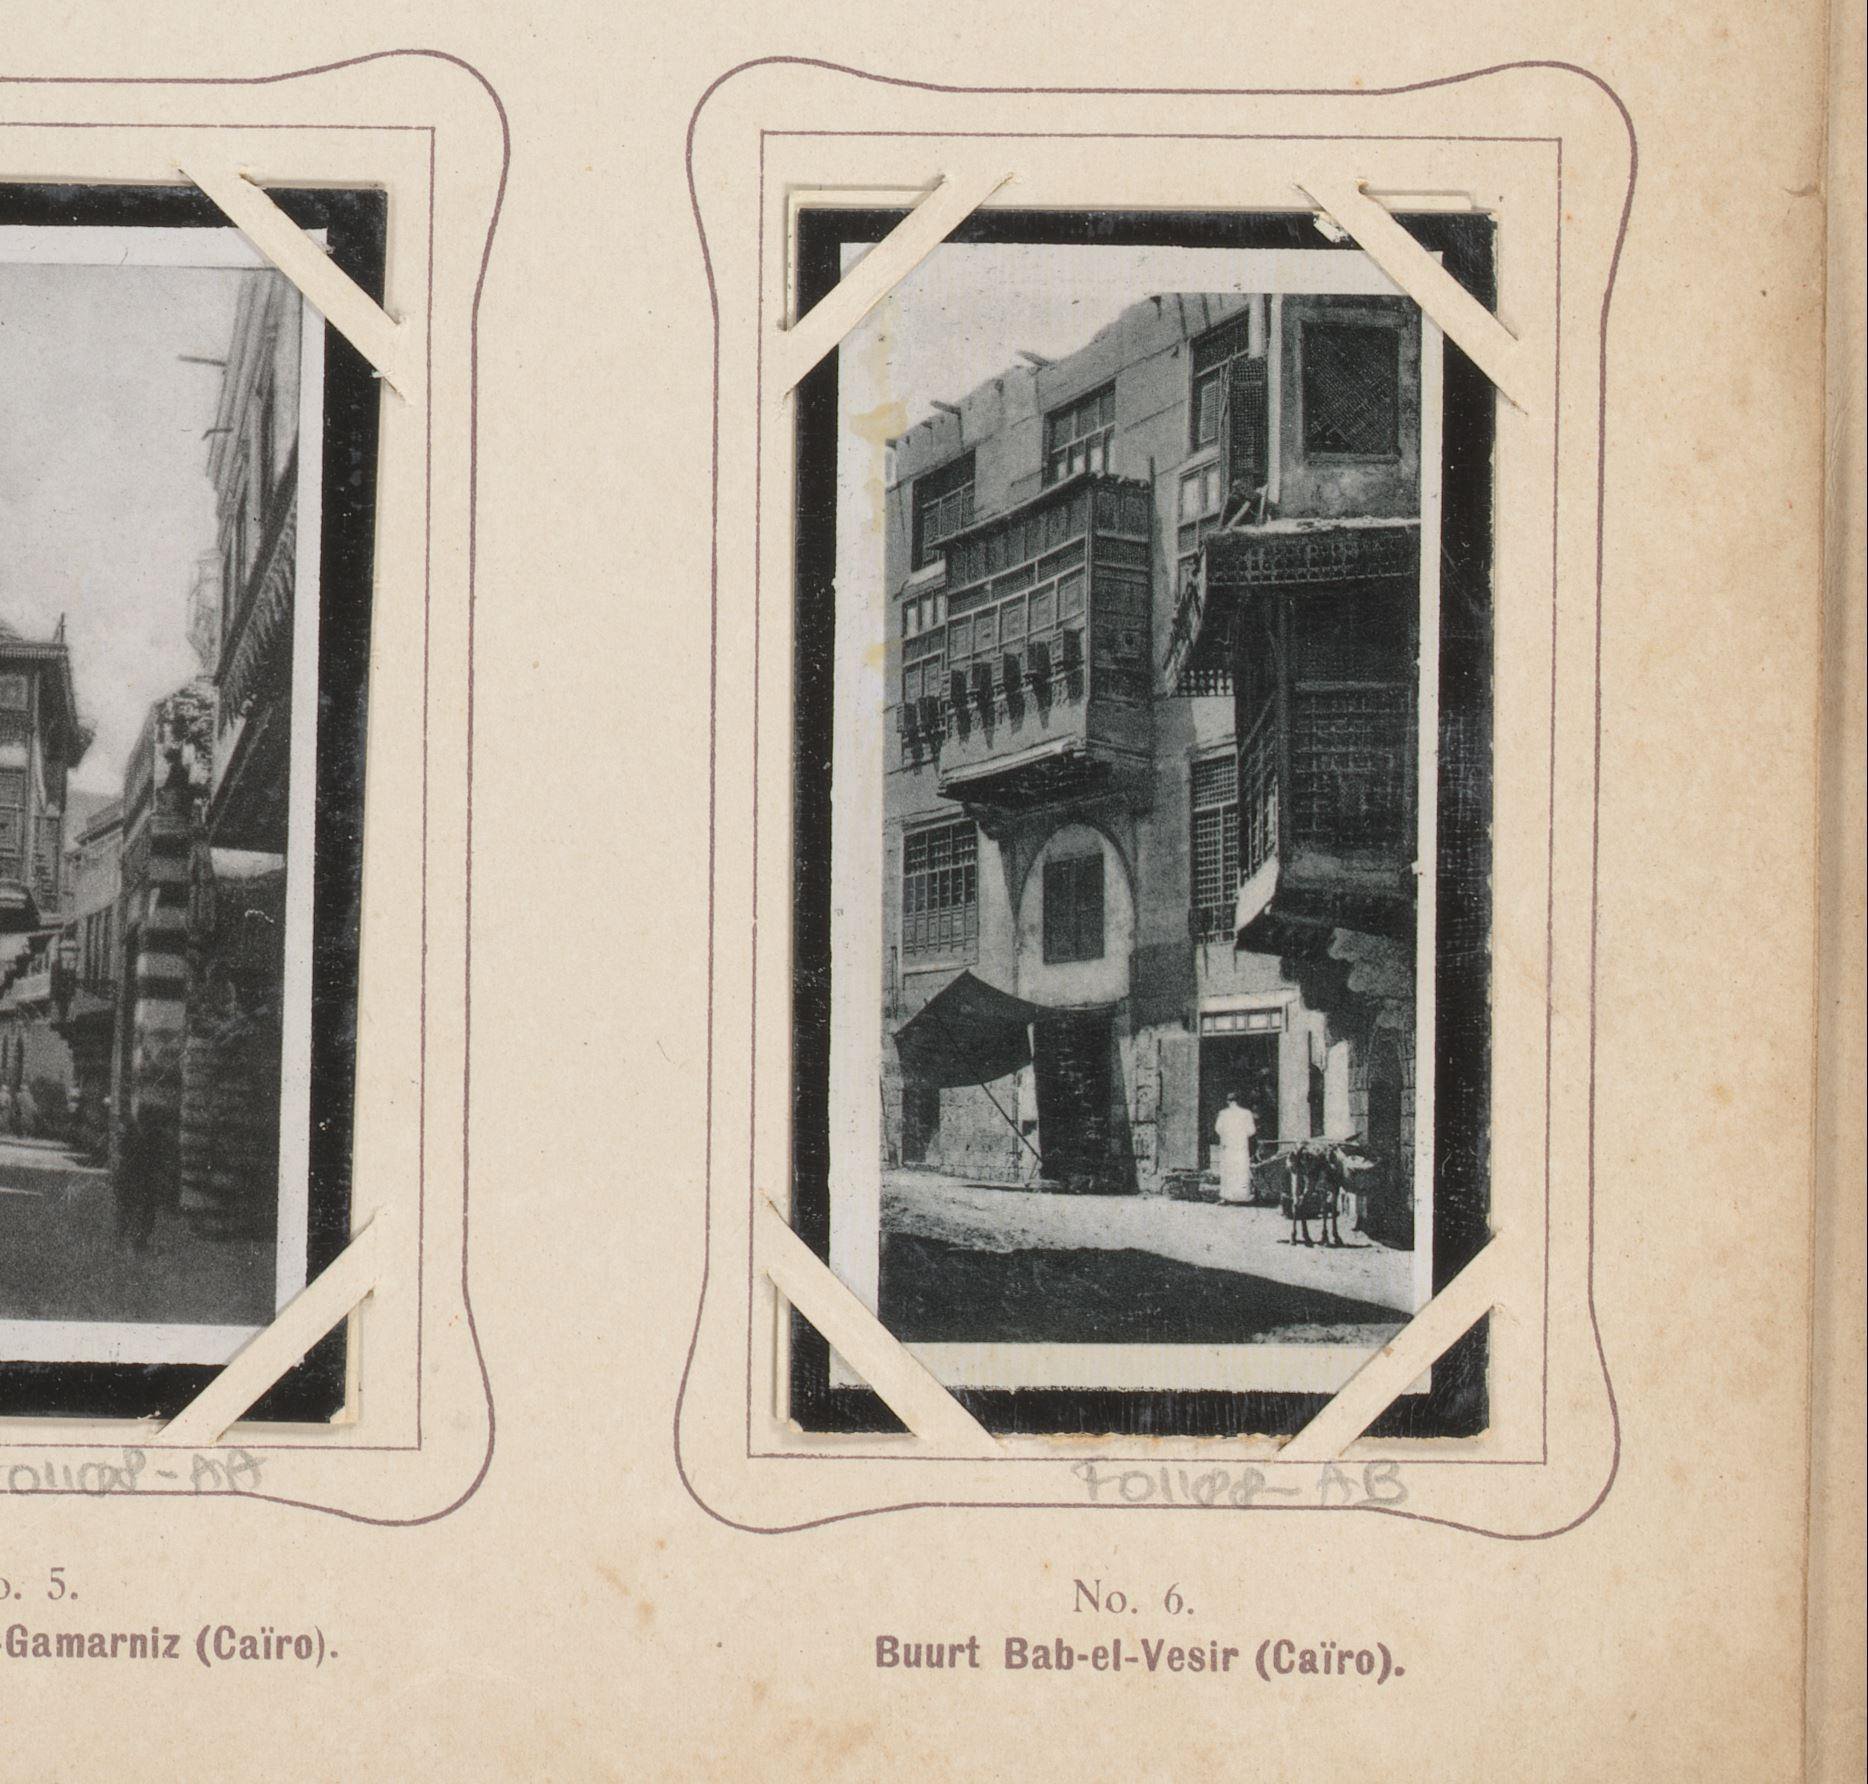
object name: photomechanical print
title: Straatgezicht te Caïro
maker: Anonymous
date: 1906-1907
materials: paper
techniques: photograph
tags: street (+ city(-scape) with figures, staffage)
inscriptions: inscription: ‘No. 6./ Buurt Bab-el-Vesir (Caïro).’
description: Deze prent maakt deel uit van een album.